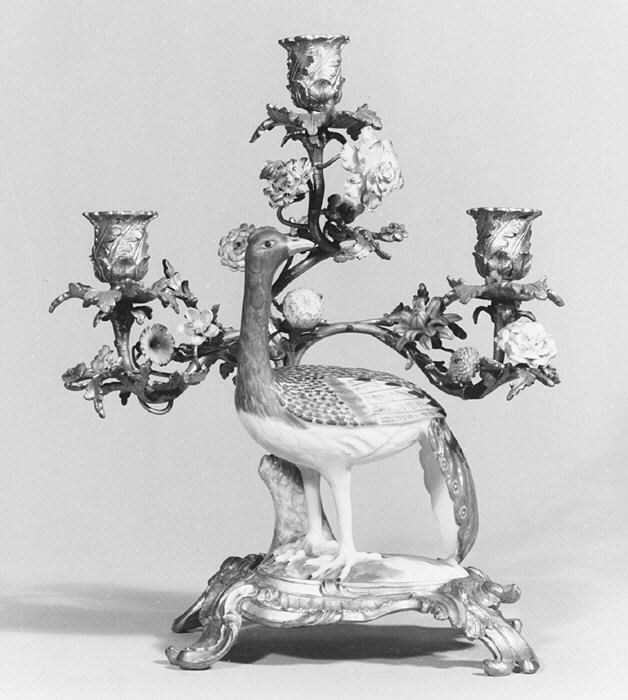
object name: candelabrum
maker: meissen manufactory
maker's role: manufactory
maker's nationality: german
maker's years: 1710-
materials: gilt bronze, hard paste porcelain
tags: peacocks,flowers